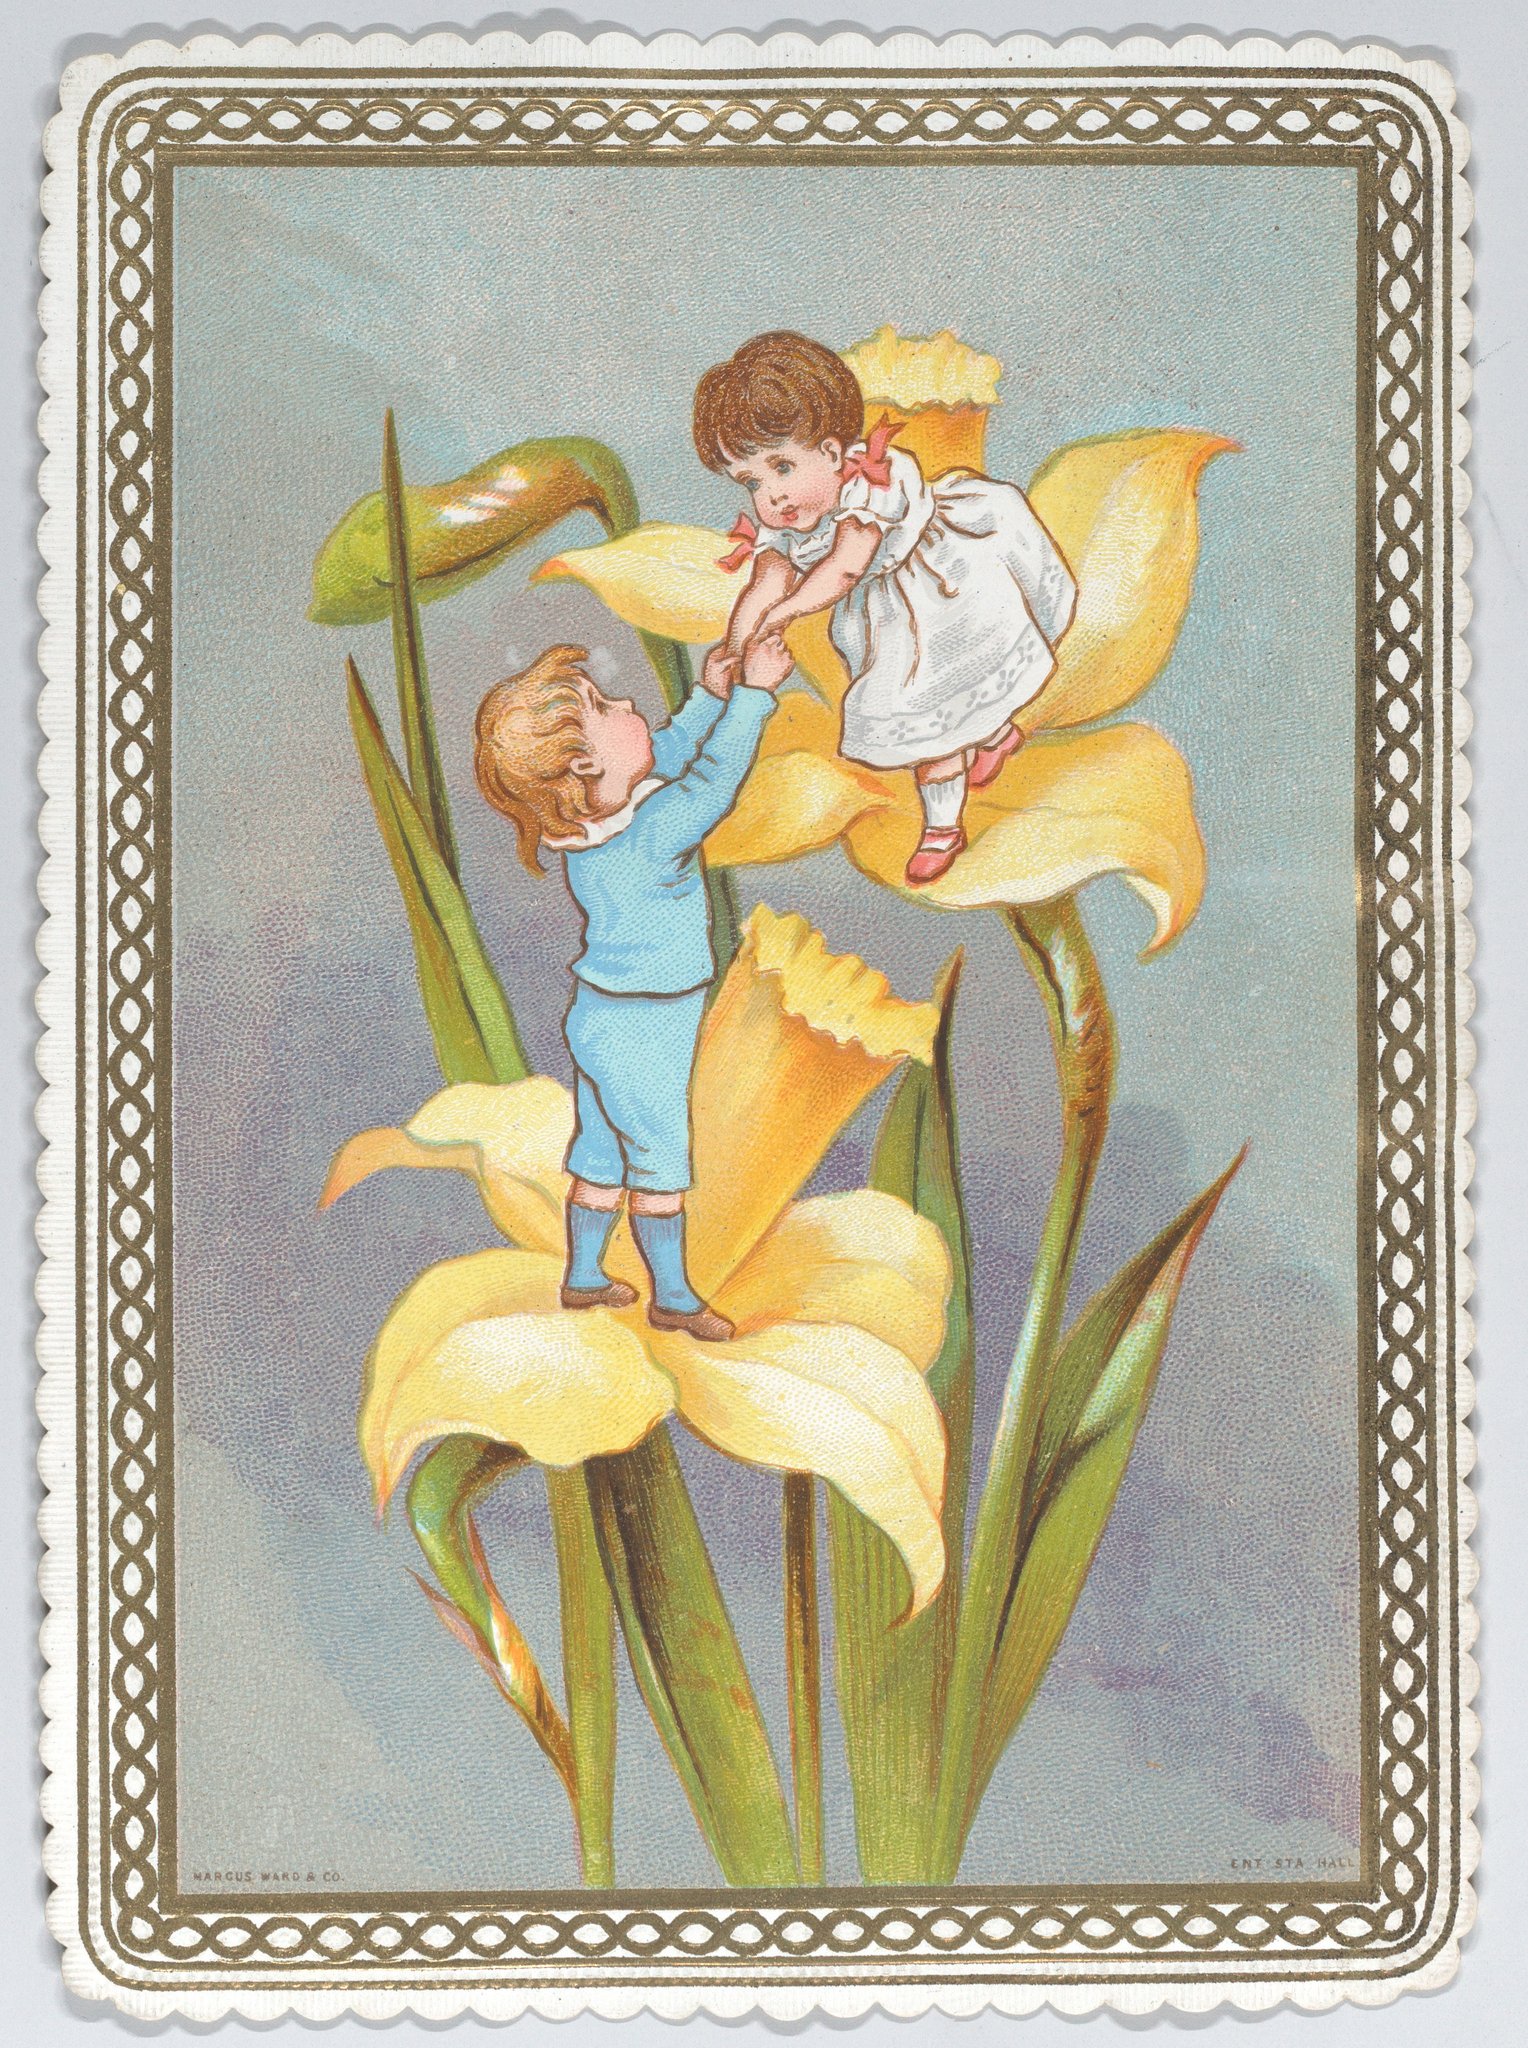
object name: valentine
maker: kate greenaway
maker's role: artist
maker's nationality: british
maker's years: 1846-1901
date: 1875-1880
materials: gilt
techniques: chromolithography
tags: boys,girls,flowers